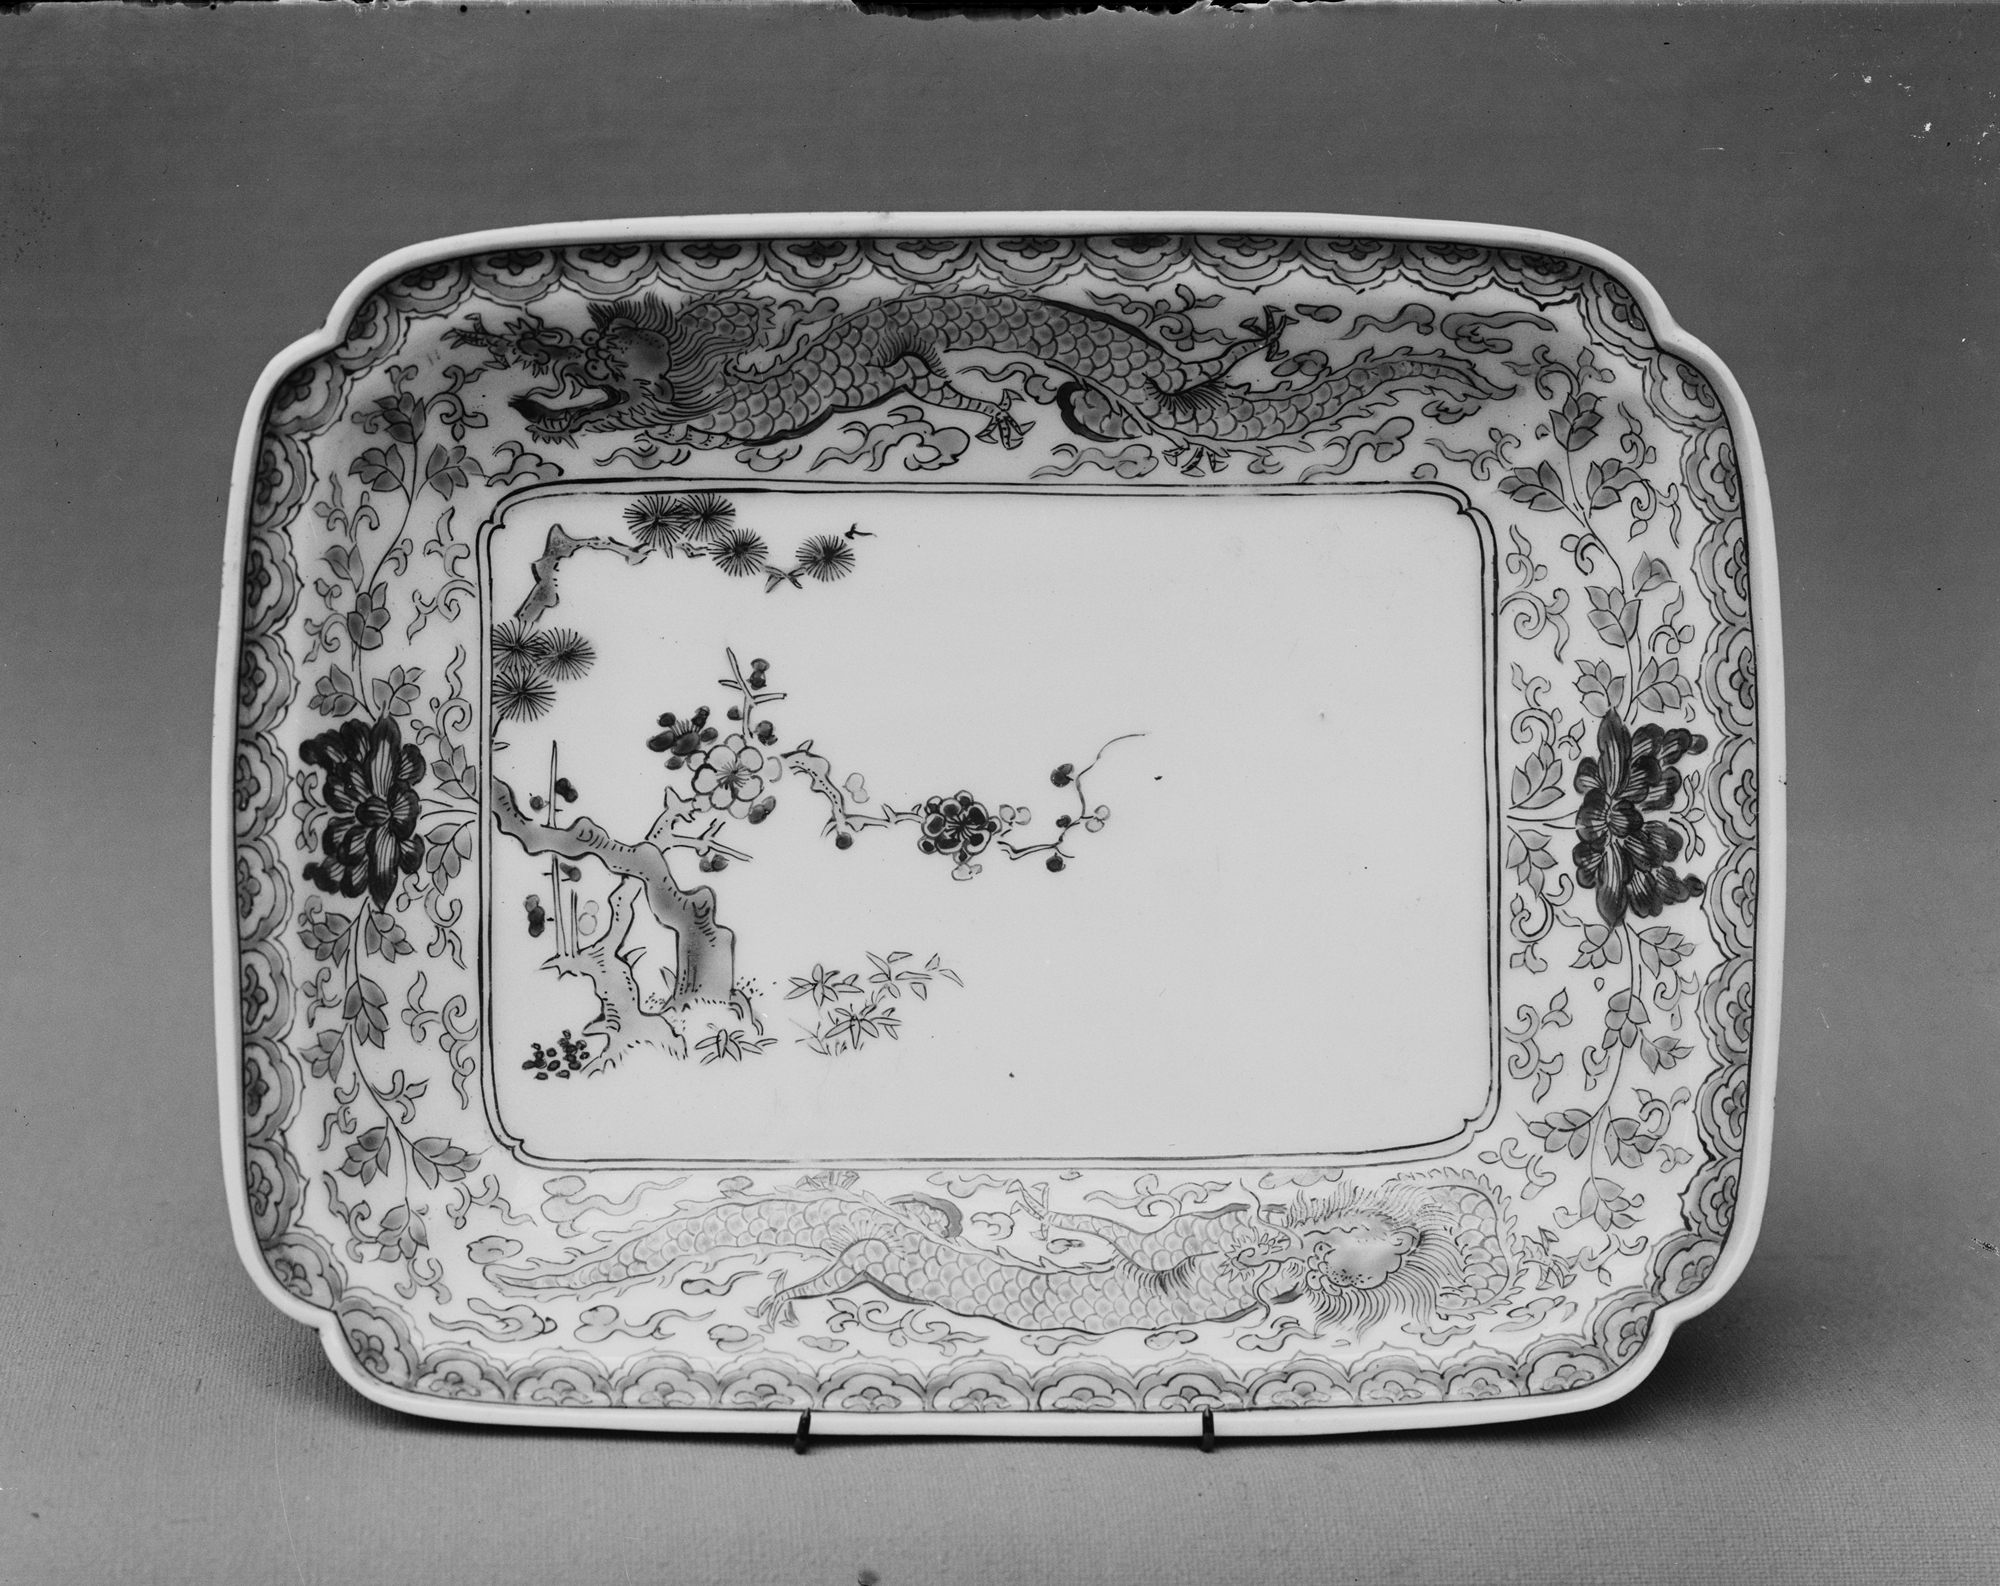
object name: dish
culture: japanese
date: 1750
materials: enamel, porcelain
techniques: polychrome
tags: dragons,trees